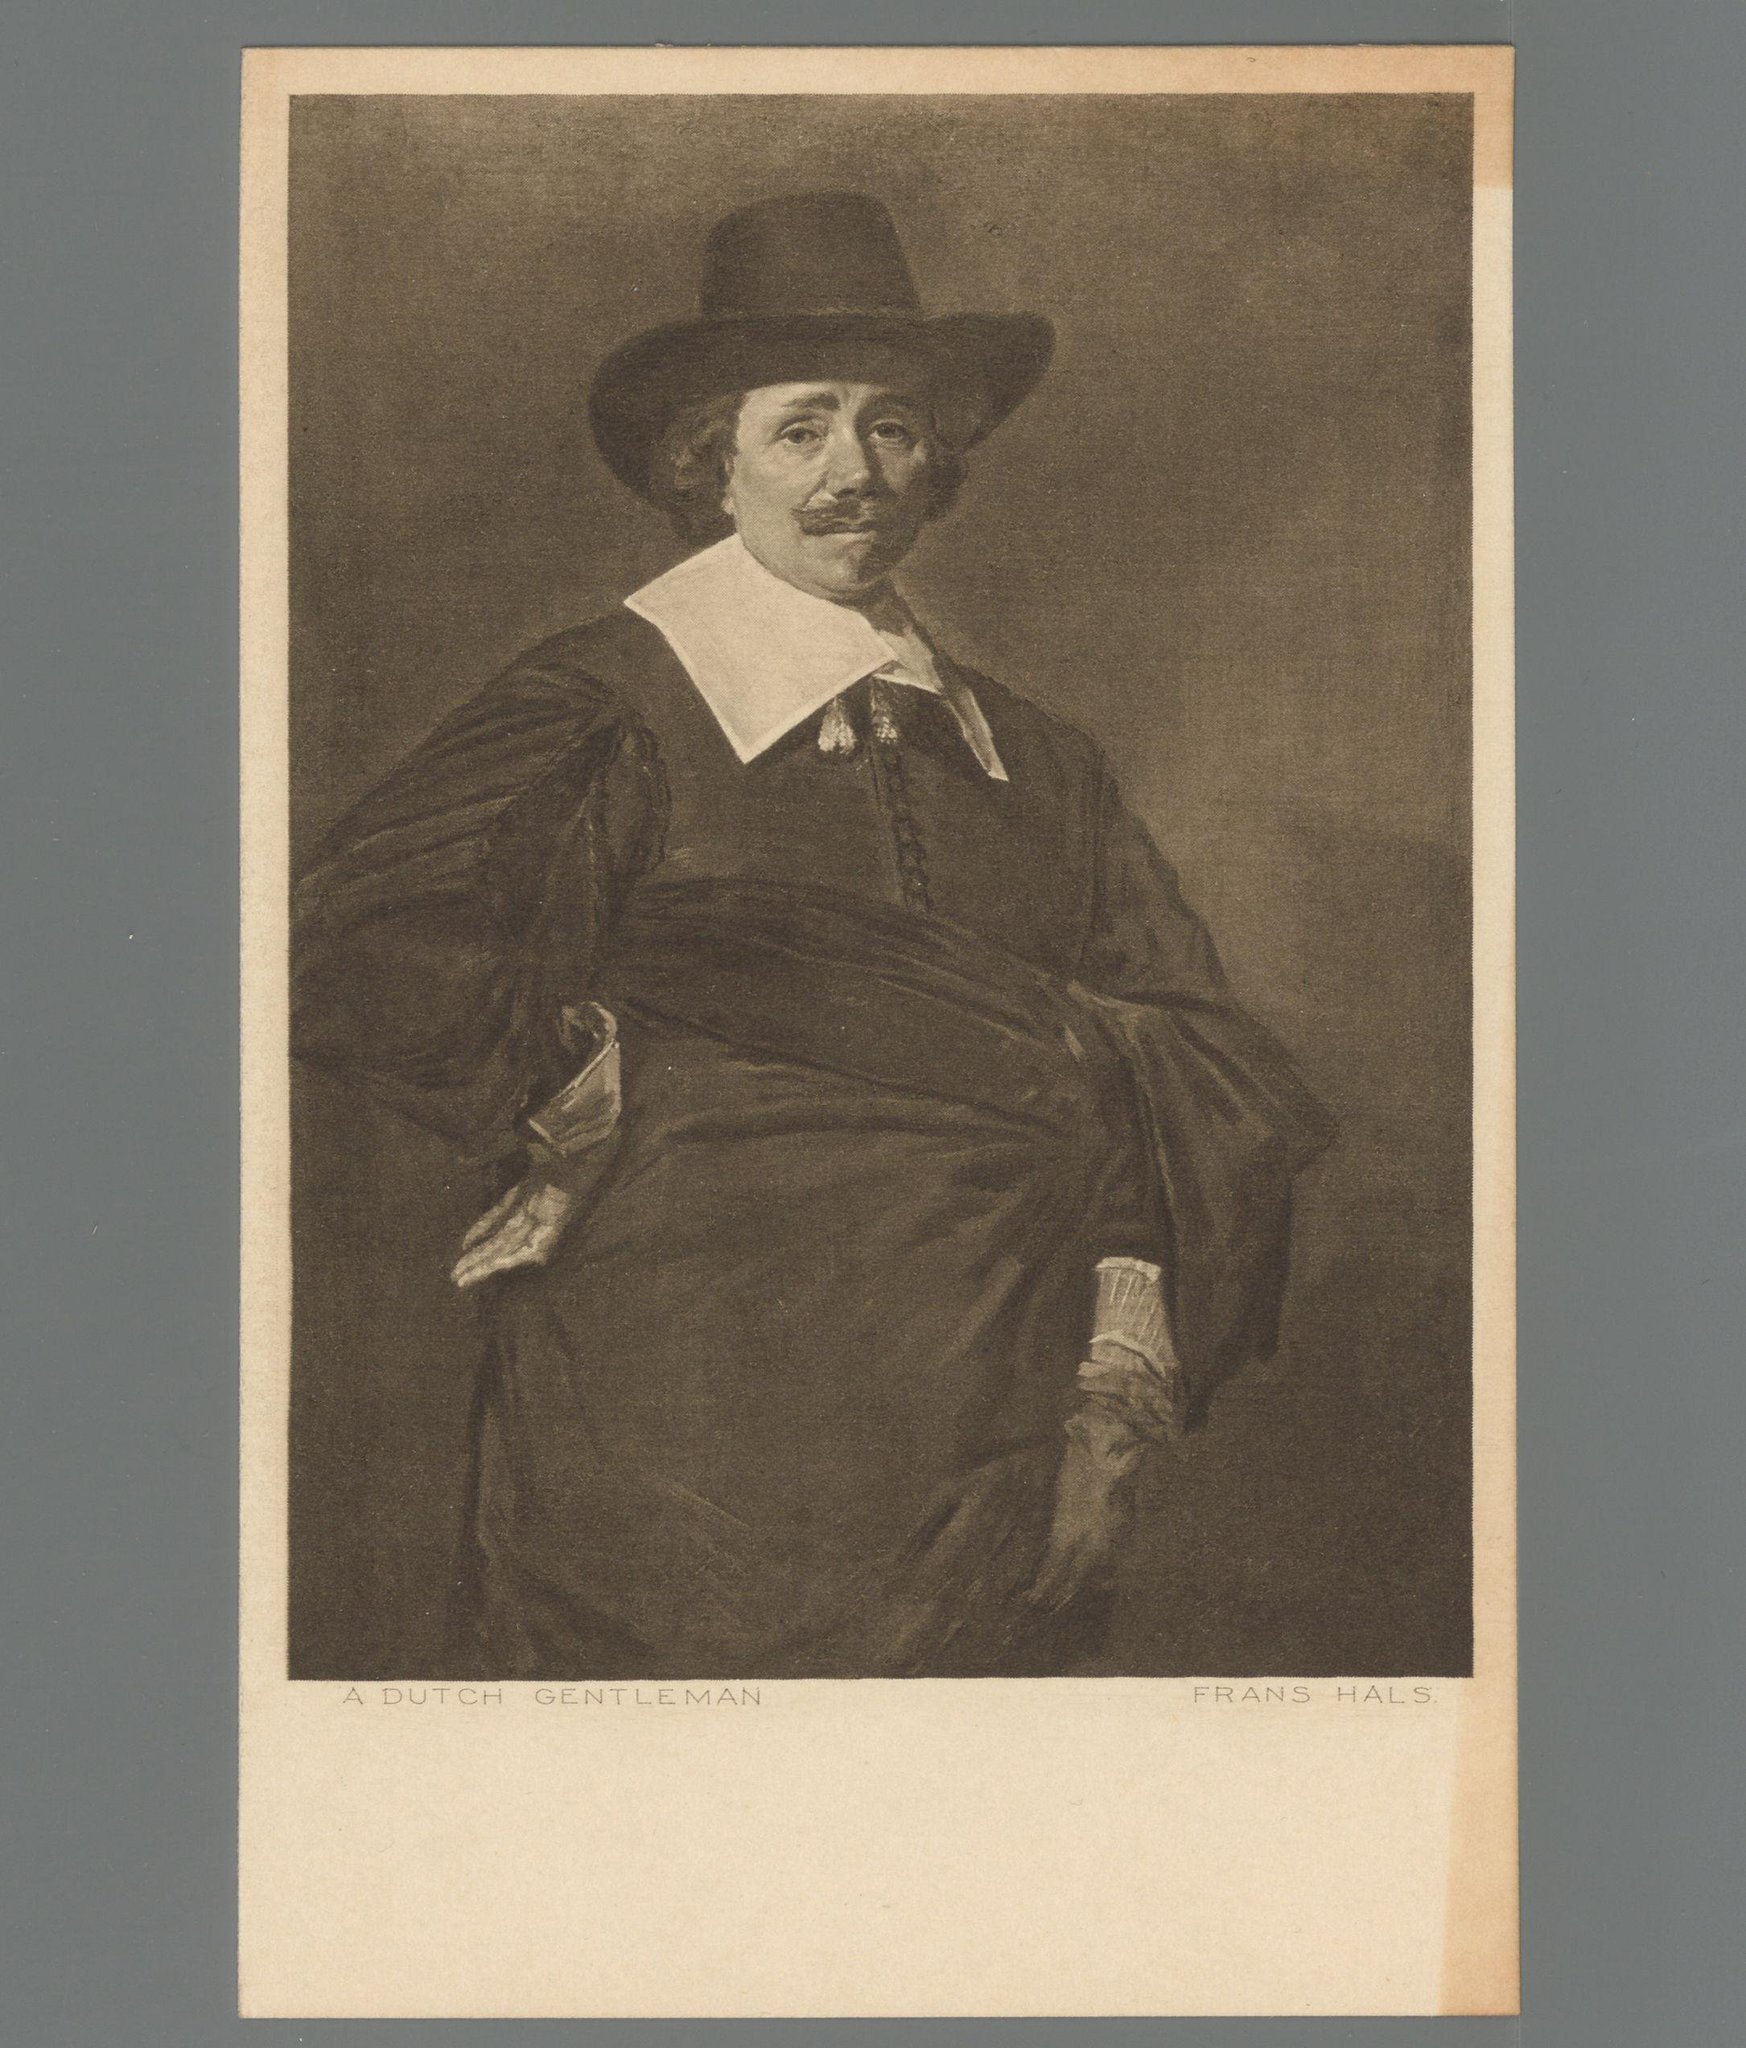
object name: photomechanical print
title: A Dutch Gentleman. Frans Hals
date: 1902-1930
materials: cardboard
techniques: rotogravure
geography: glasgow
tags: historical persons, permanent exhibition, museum, picture, painting